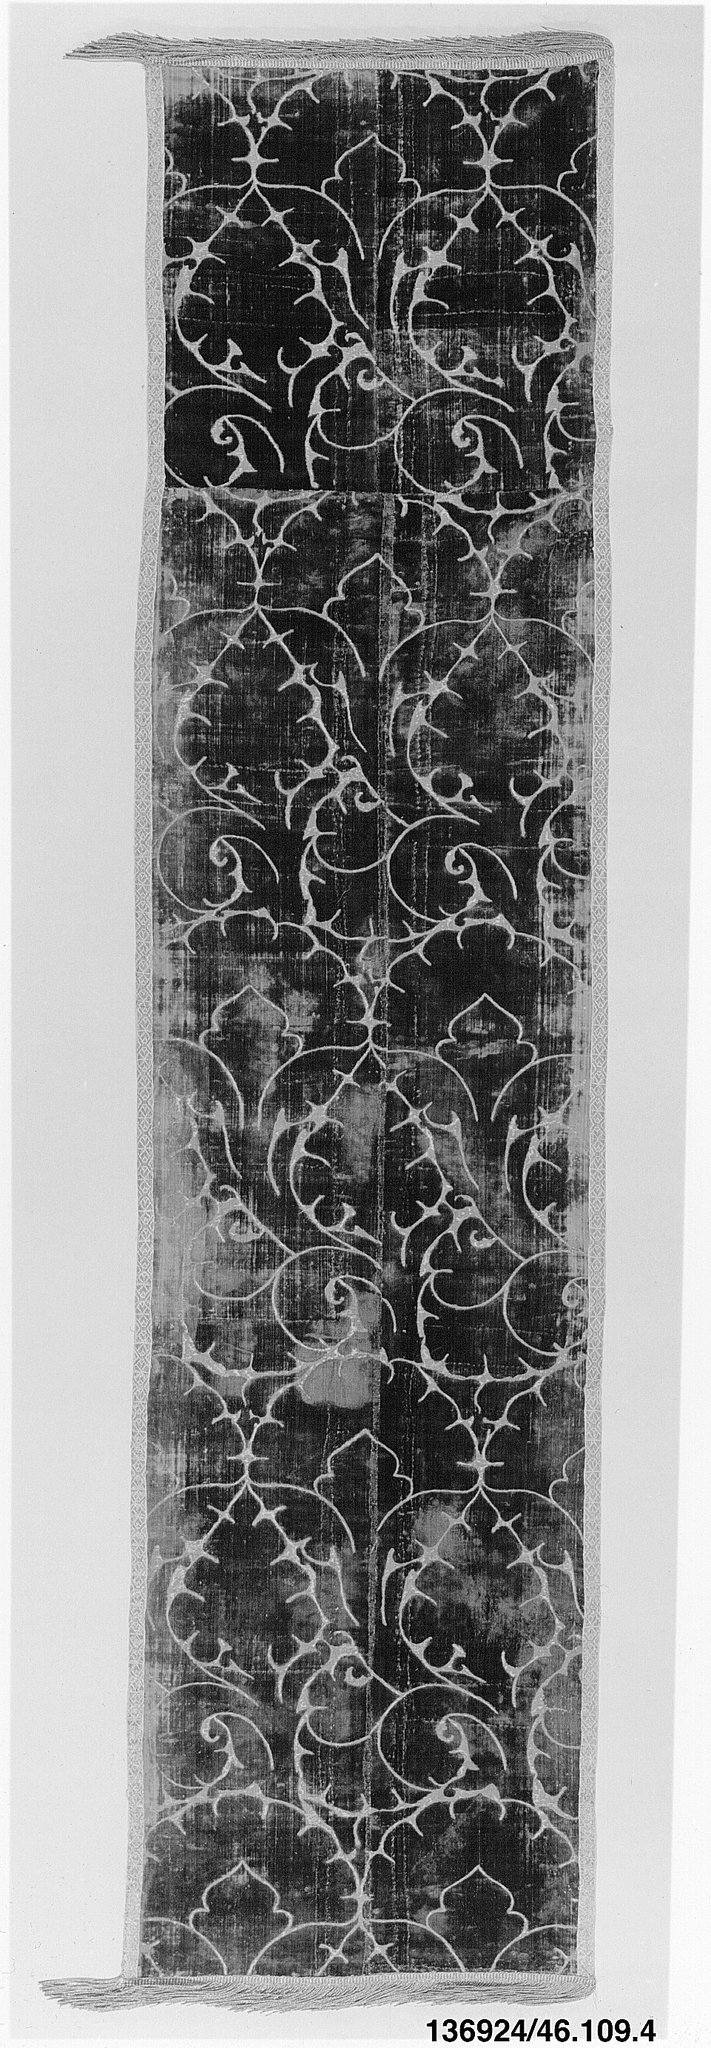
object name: piece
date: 1401-1500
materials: silk